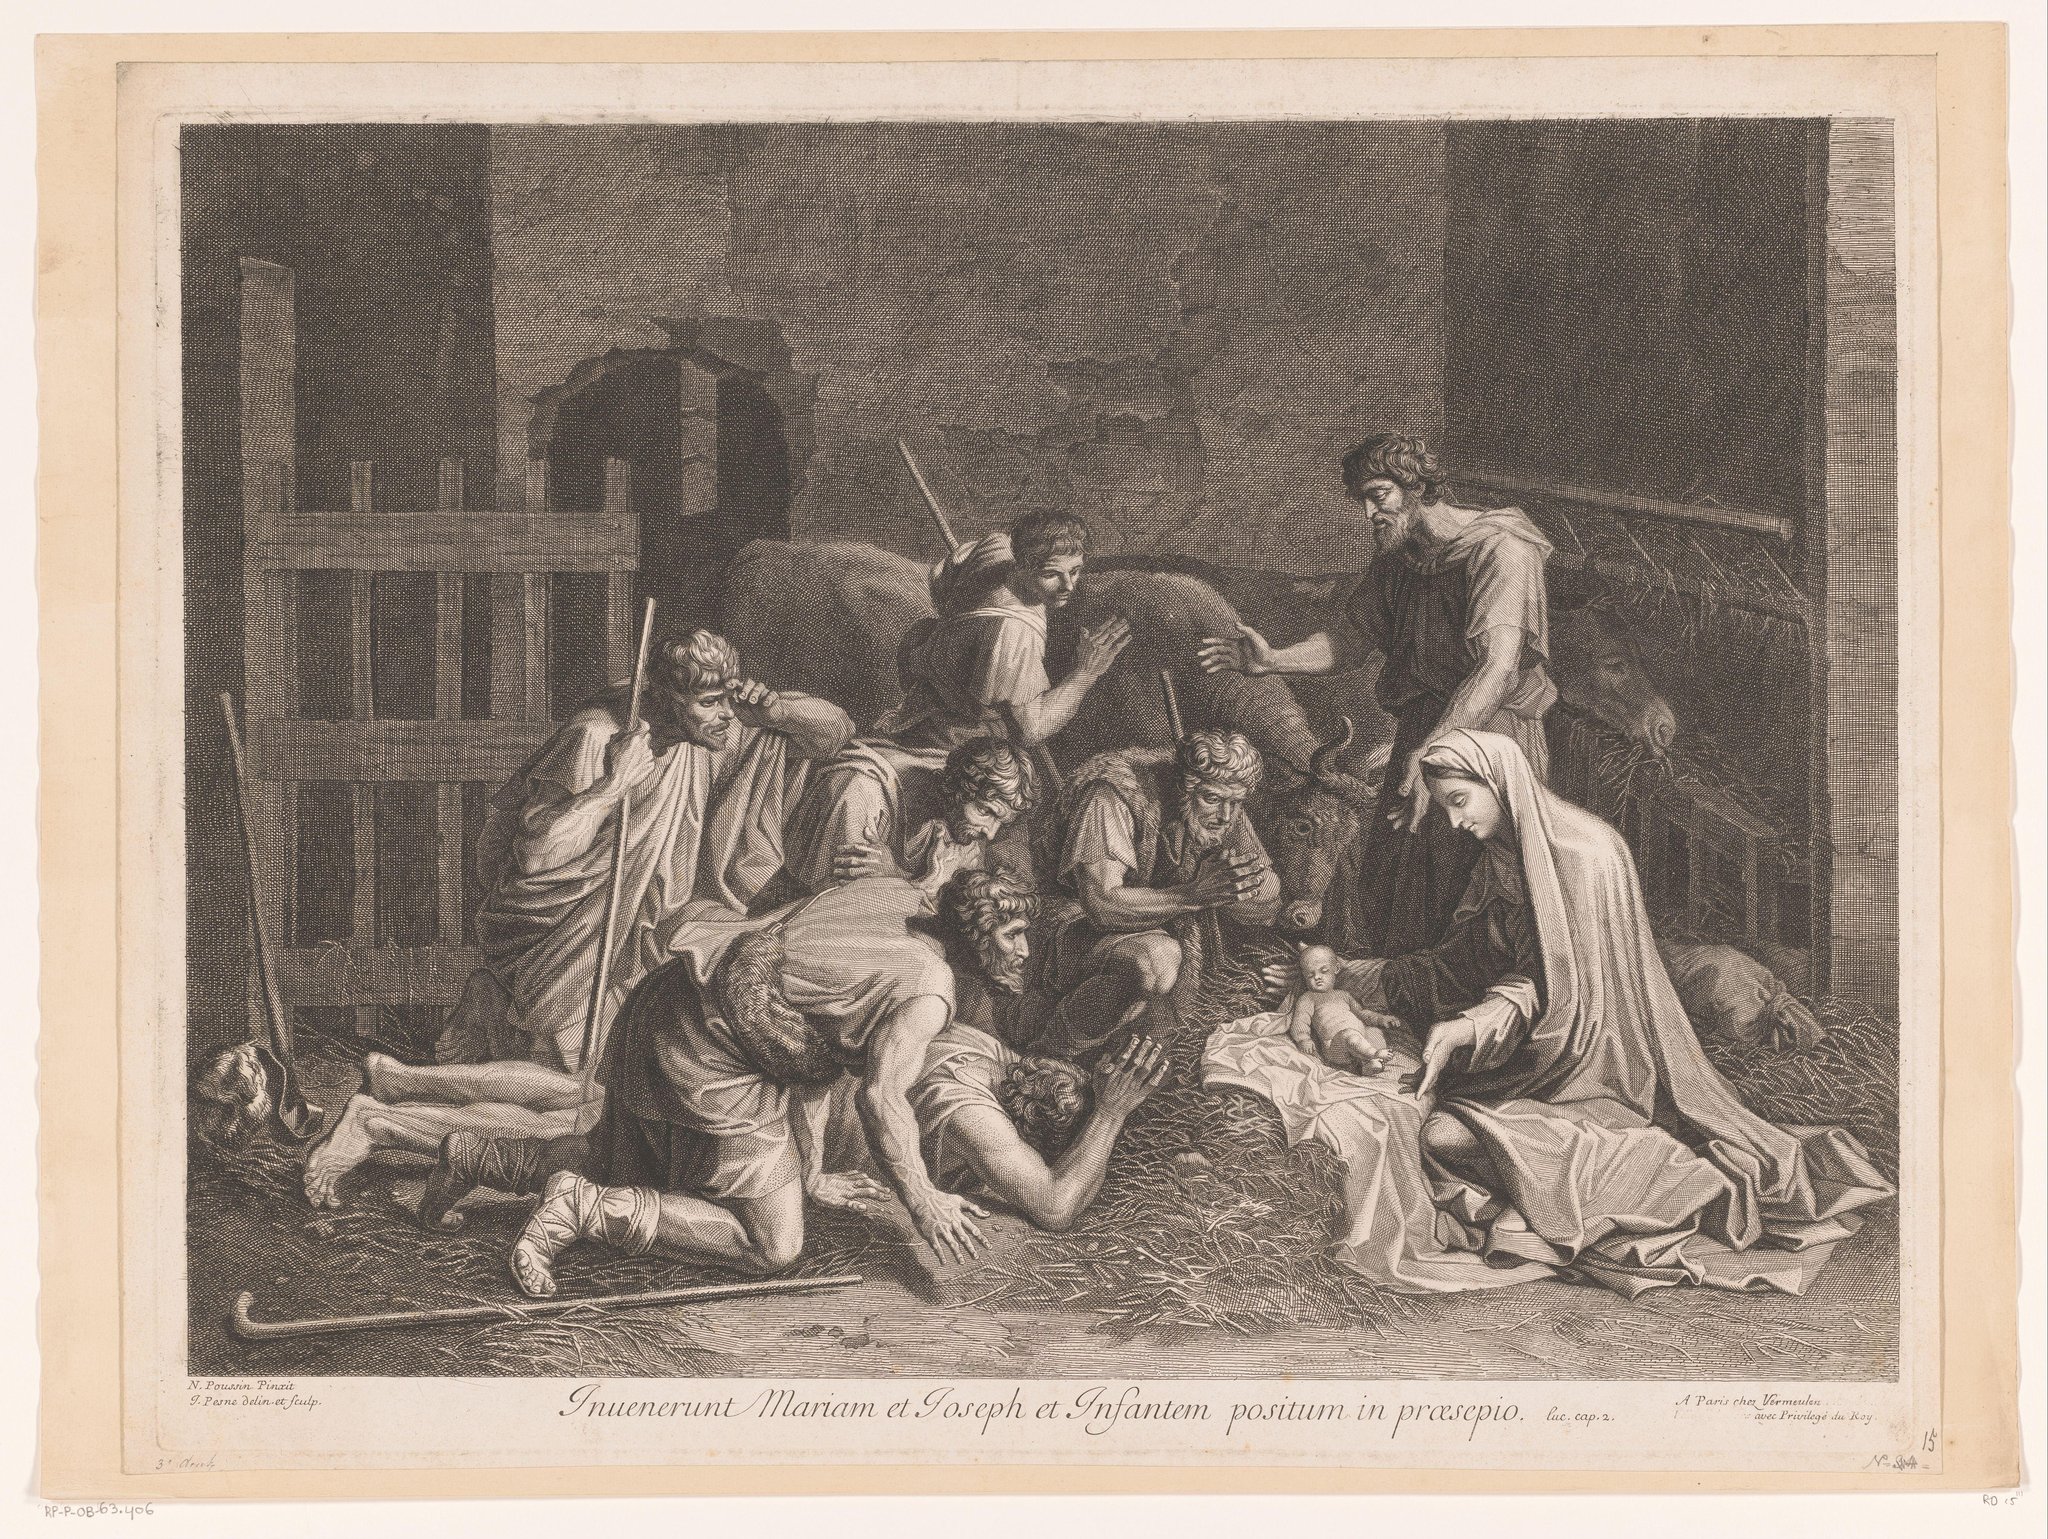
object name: print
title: Aanbidding door de herders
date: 1633-1700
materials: paper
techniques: etching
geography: paris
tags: adoration of the christ-child by the shepherds; mary and joseph present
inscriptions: collector's mark: Lugt 240